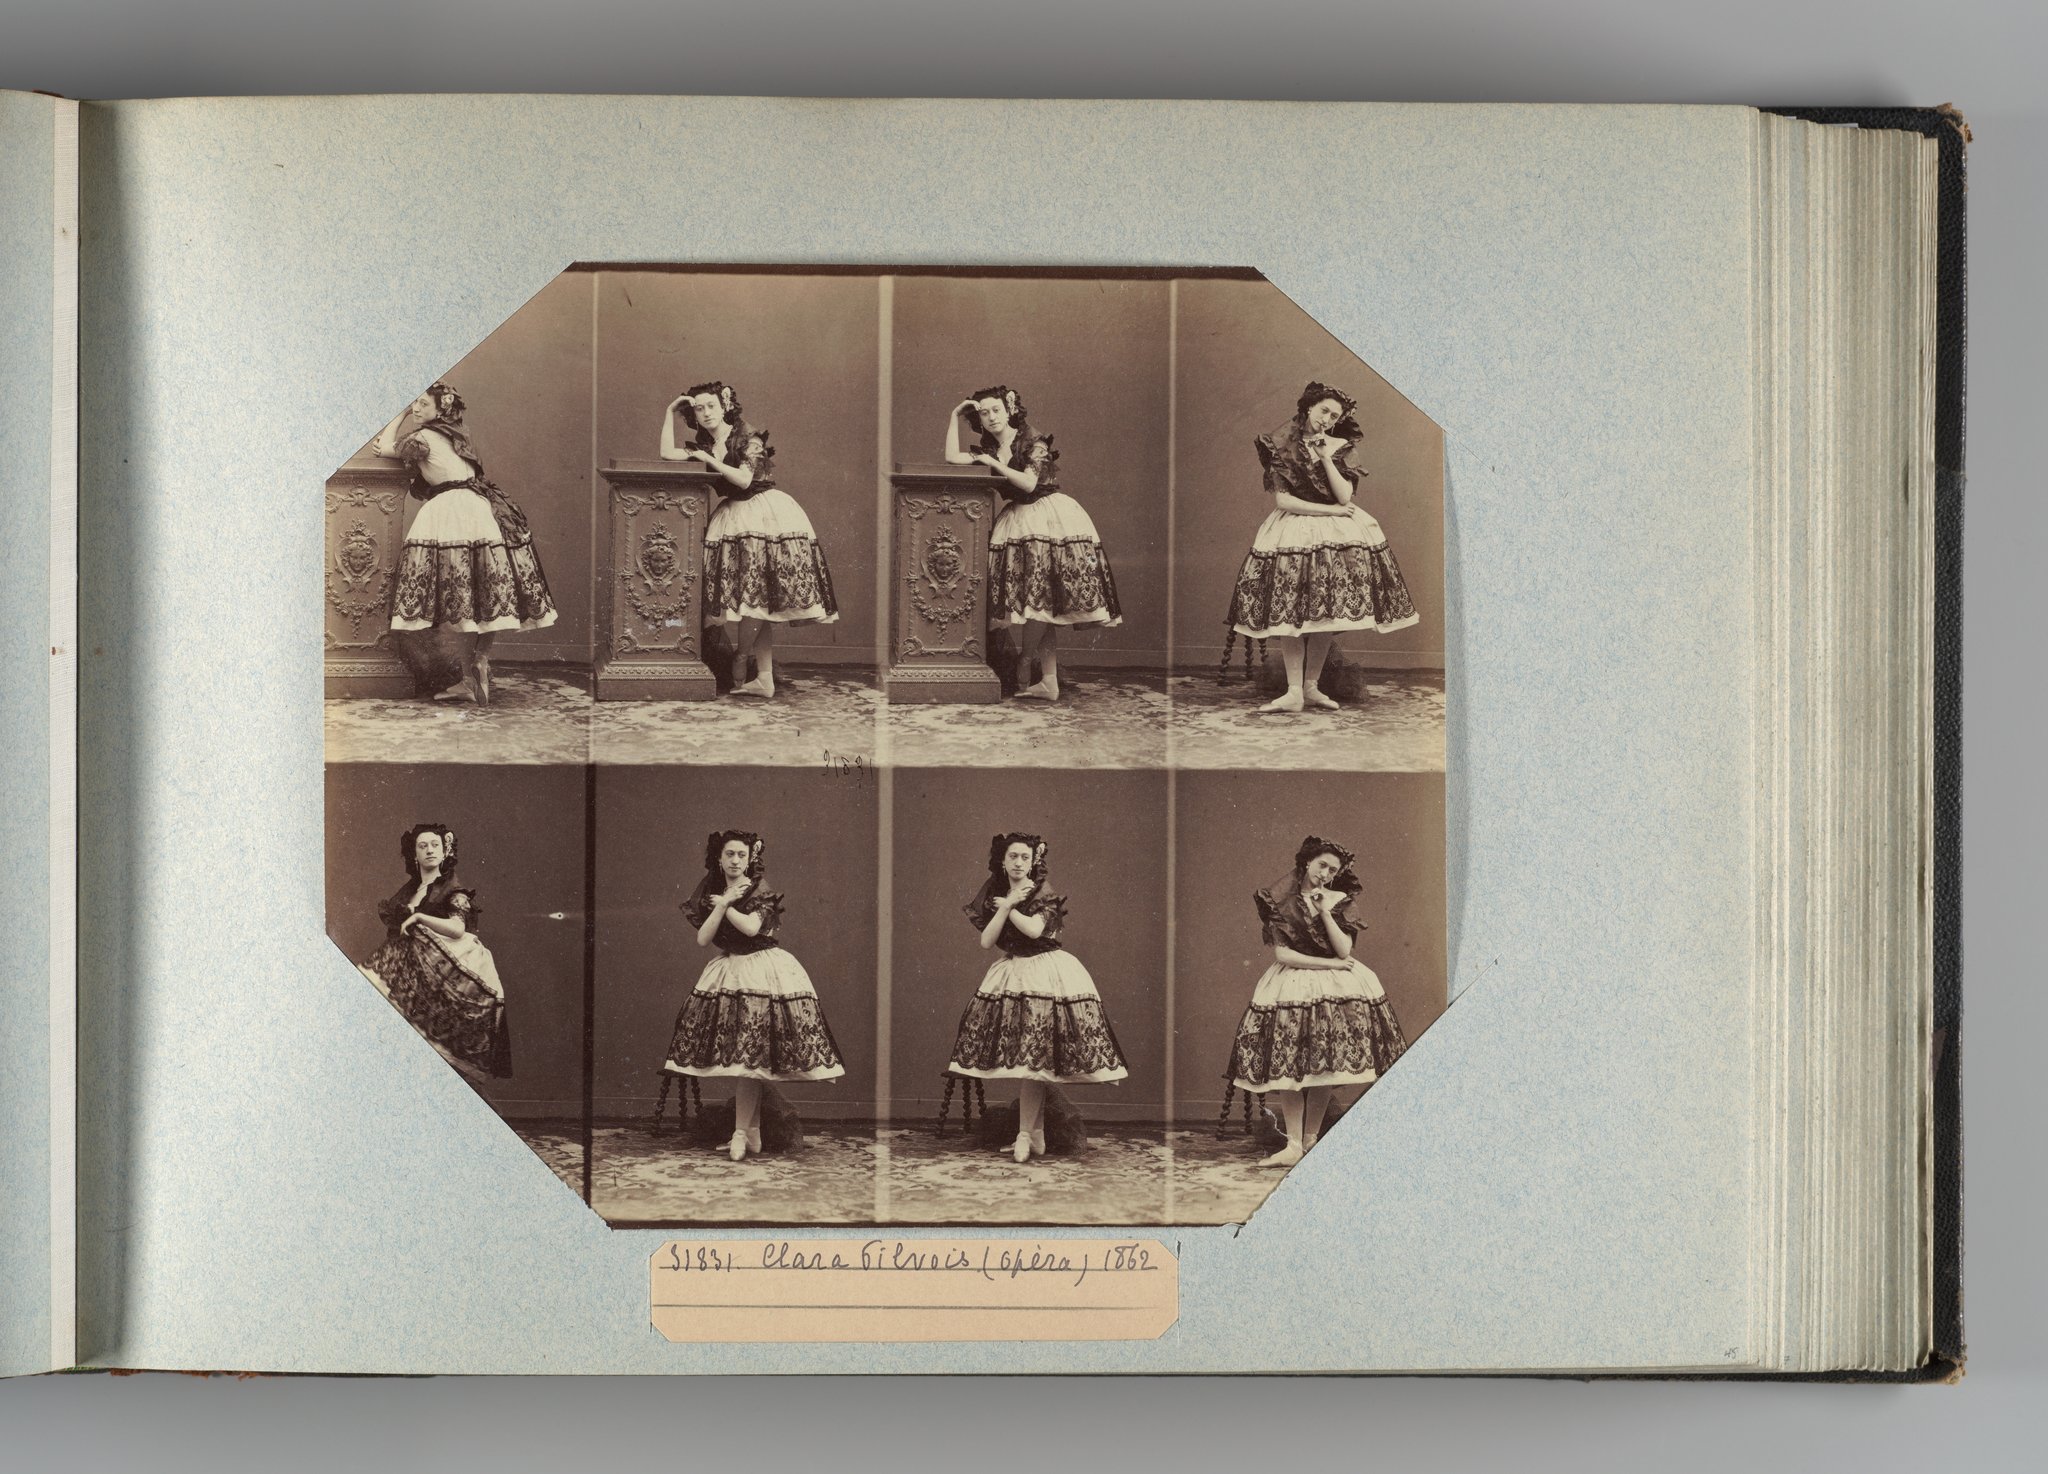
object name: photograph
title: Clara Pilvois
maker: andré-adolphe-eugène disdéri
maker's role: artist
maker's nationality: french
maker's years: 1819-1889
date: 1862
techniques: albumen silver print, glass negative